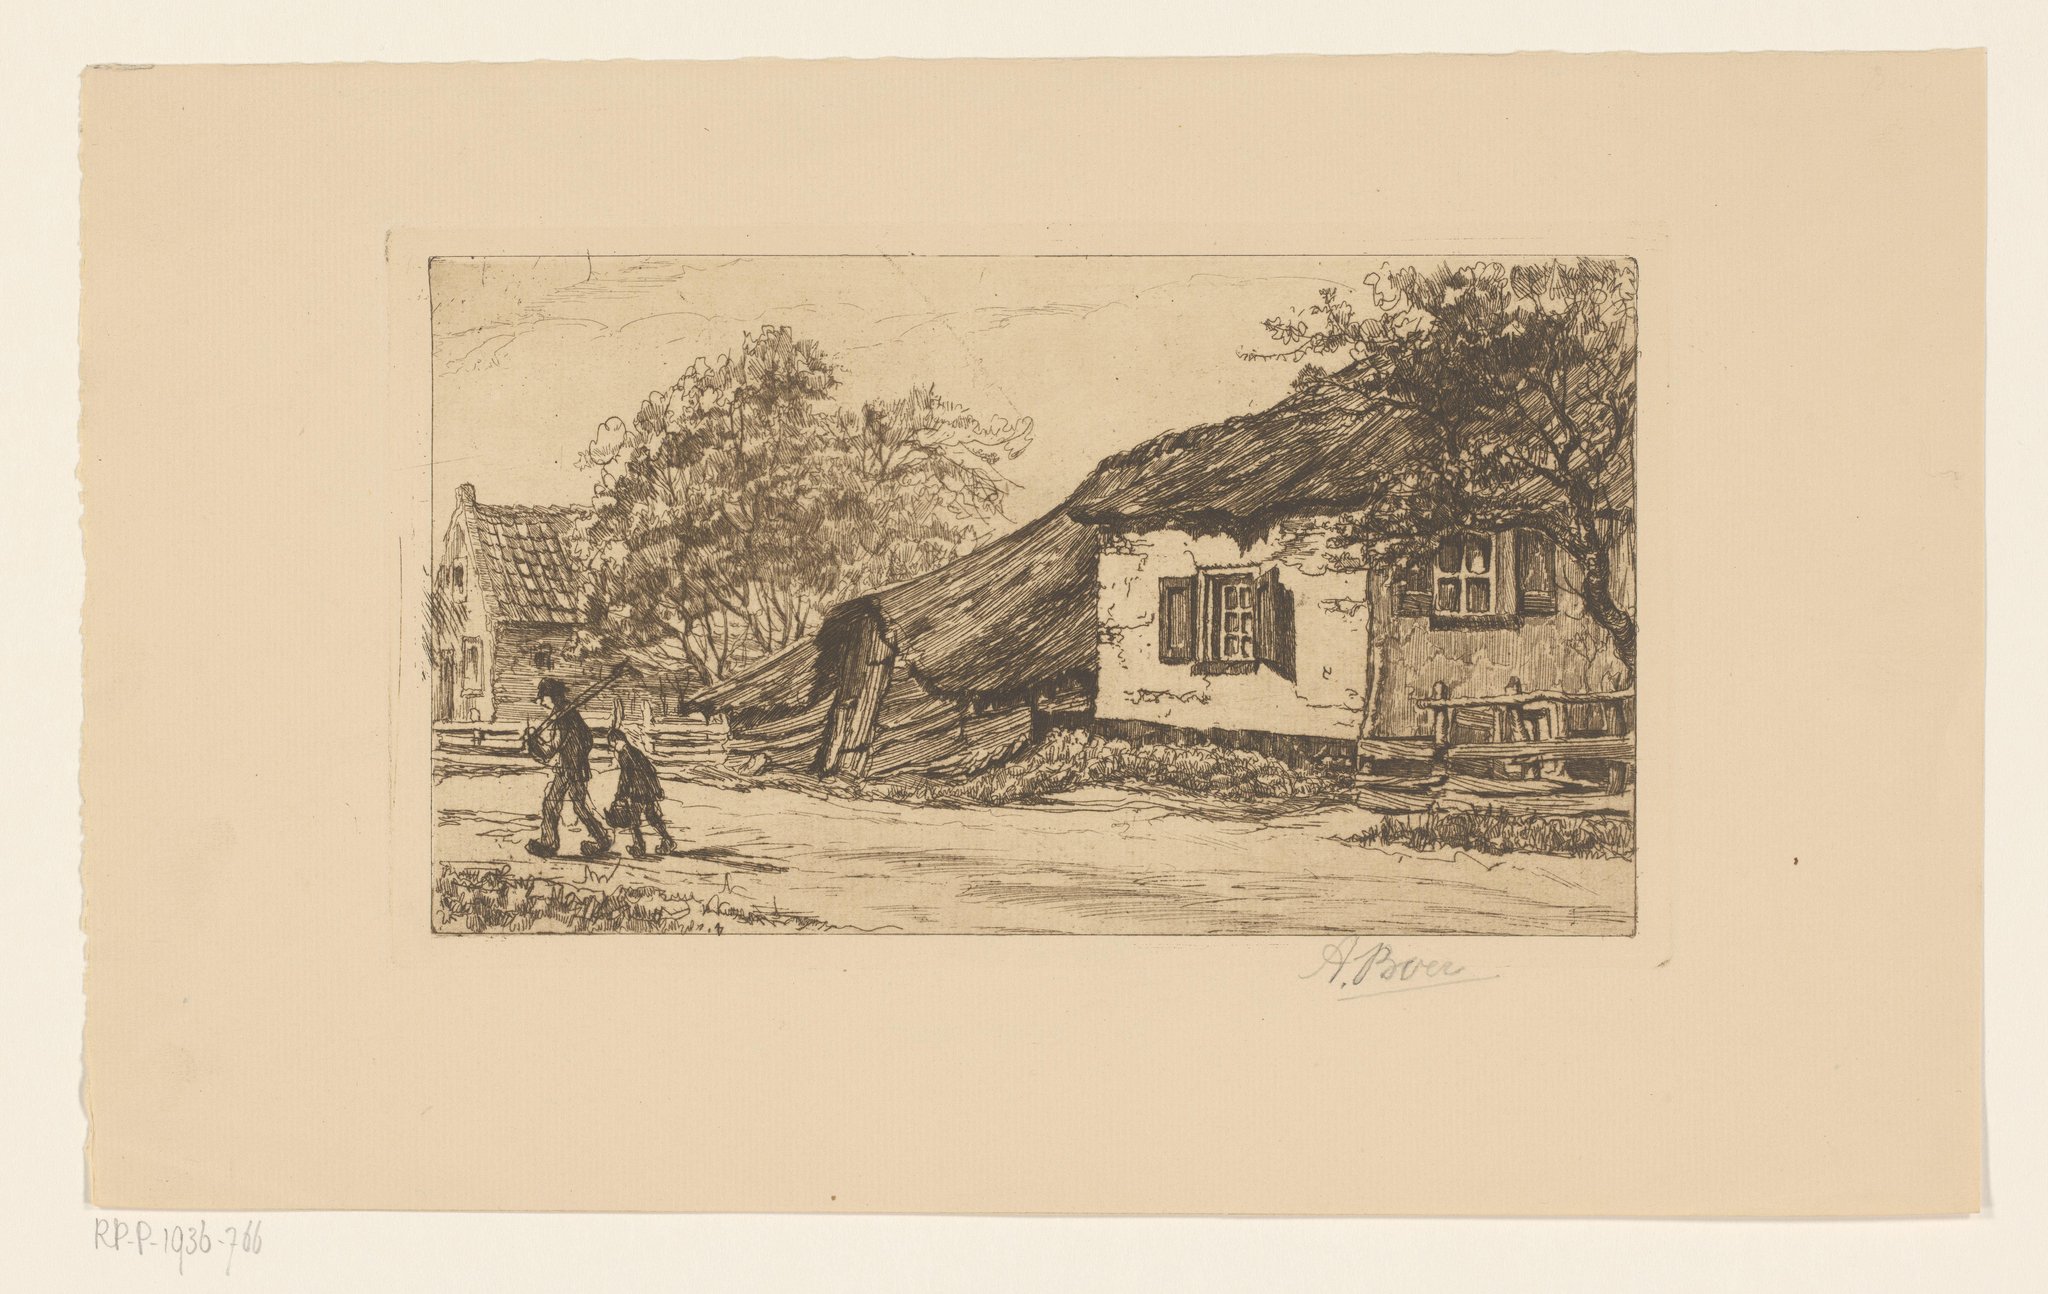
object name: print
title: Landschap met boerenhuizen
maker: arend boer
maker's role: print maker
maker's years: 1880-1933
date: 1890-1933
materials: paper, ink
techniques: drypoint, etching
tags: village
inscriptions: collector's mark: Lugt 2760, signature: ‘A. Boer’, collector's mark: Lugt 2228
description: Dorpsweg met boerenhuizen en twee lopende figuren.